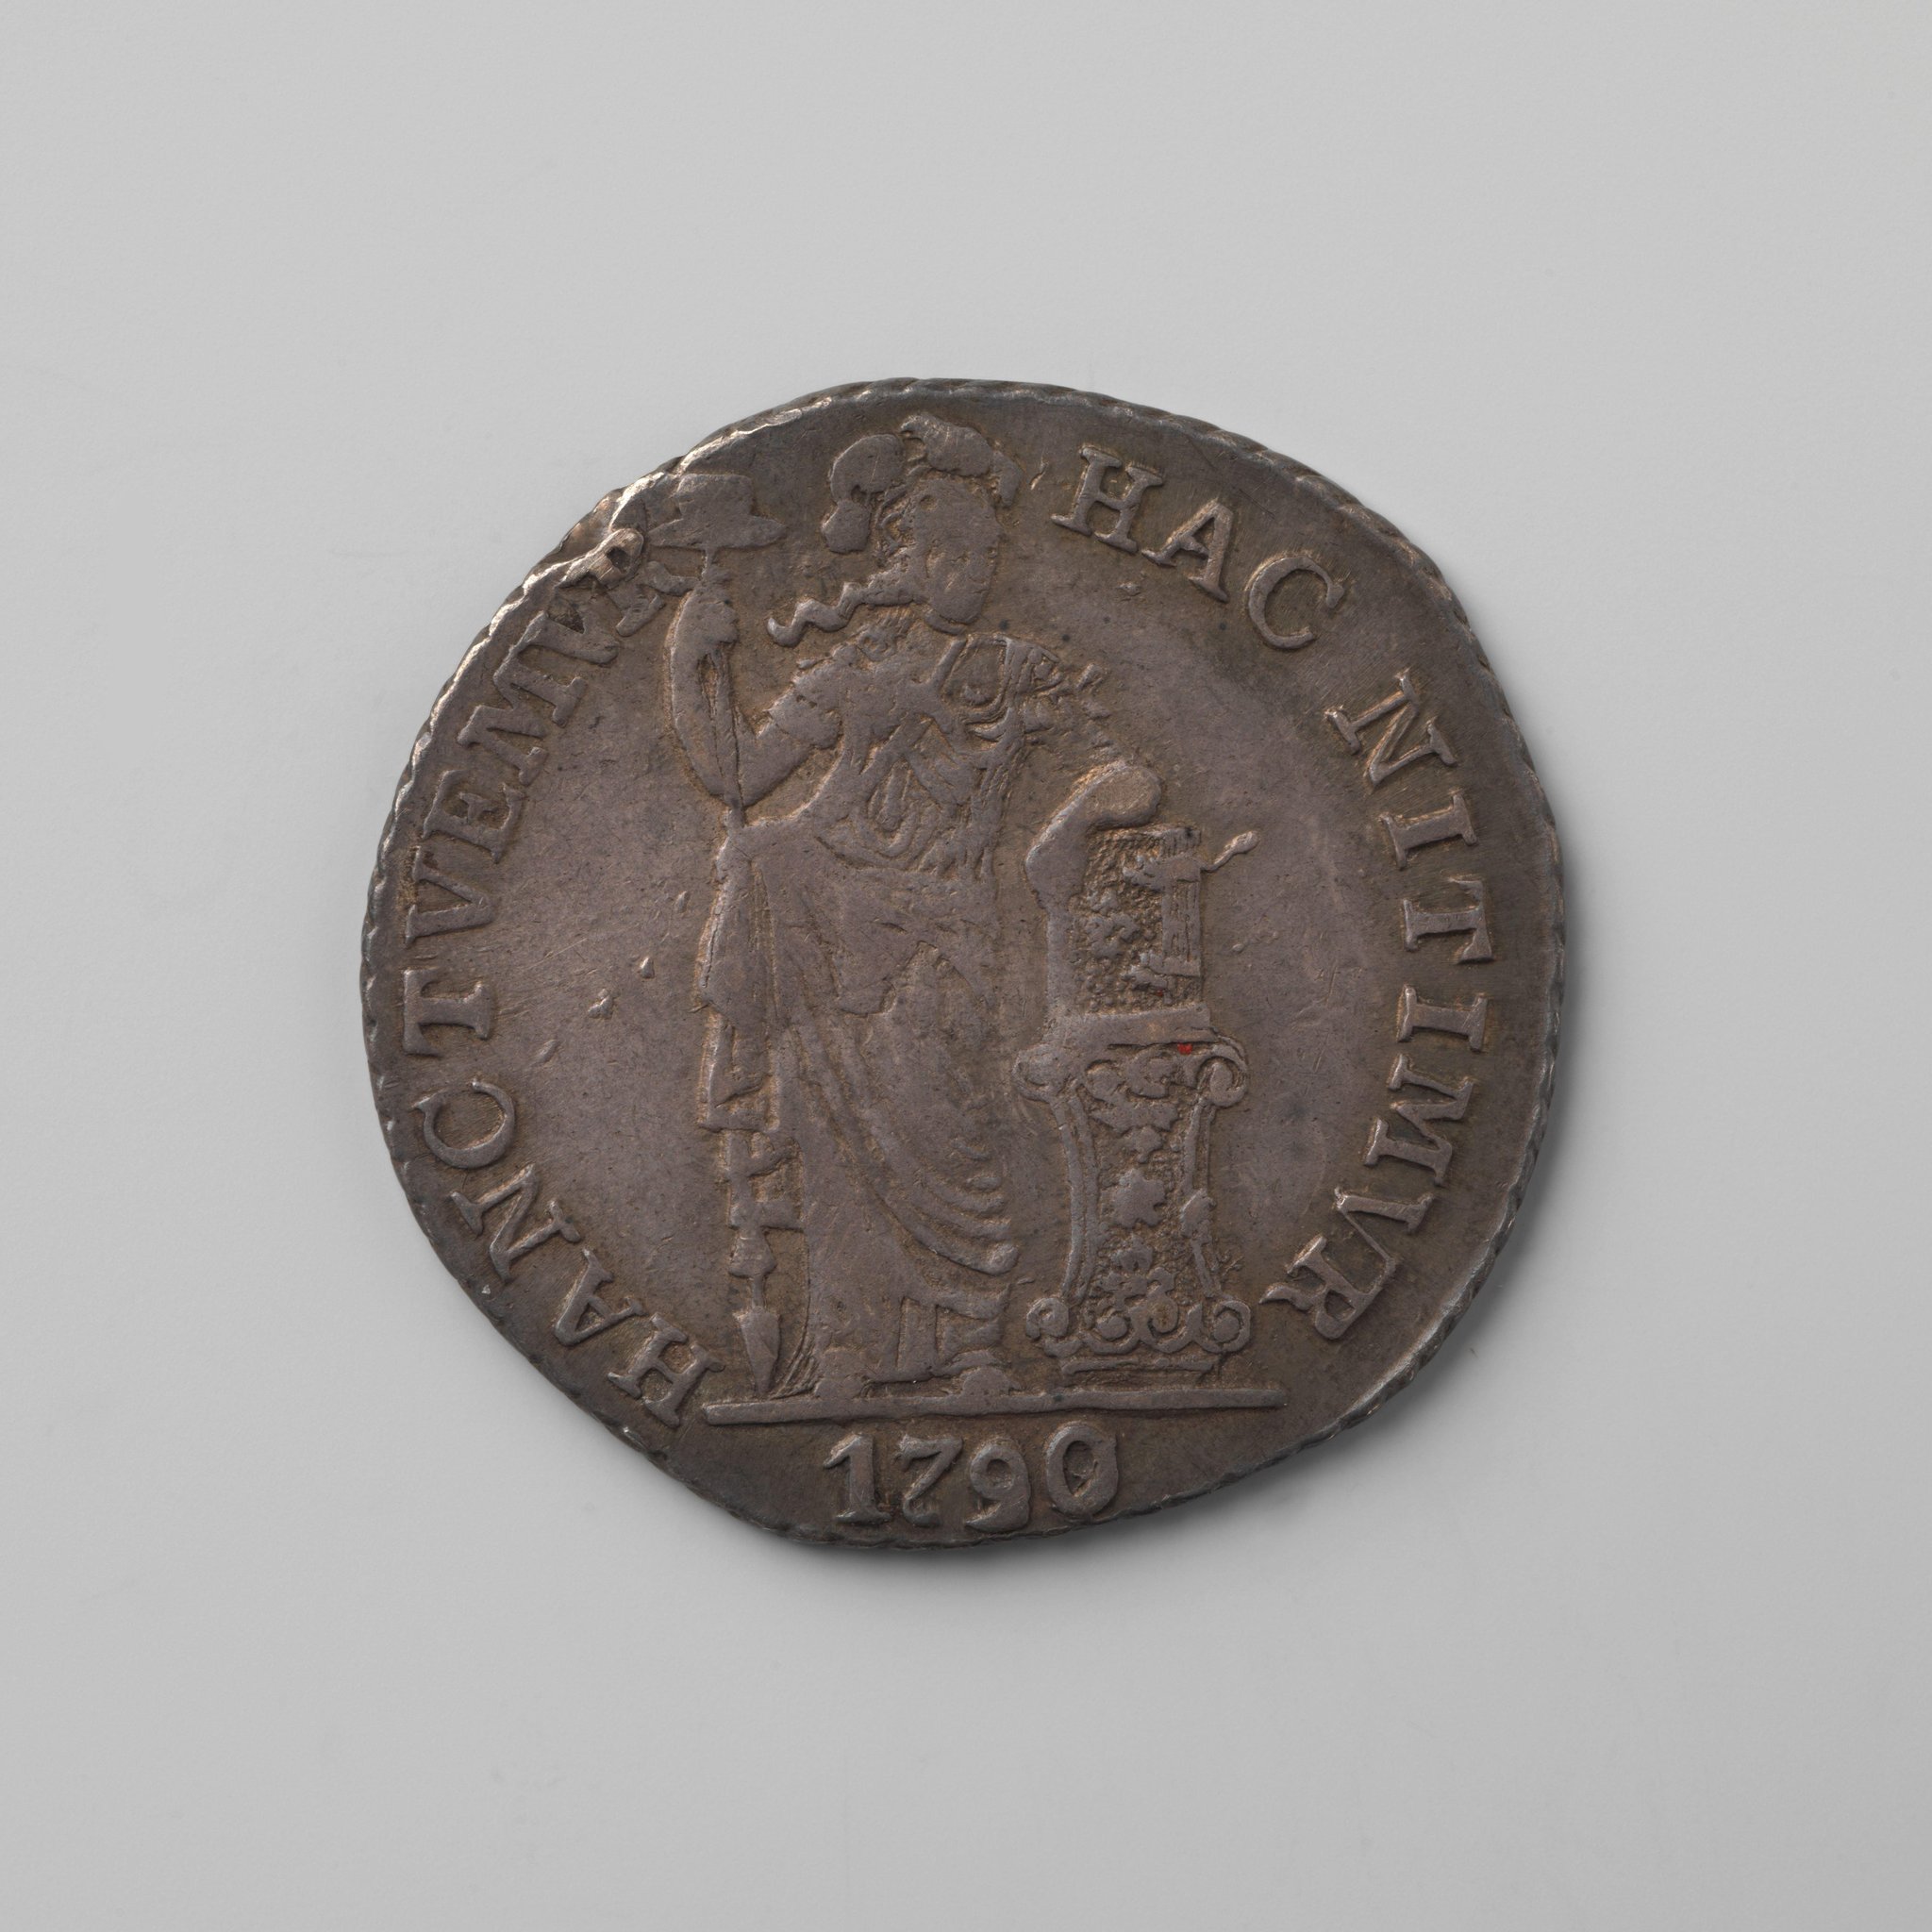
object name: coin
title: VOC, gulden, Westfriesland,1790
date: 1790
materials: silver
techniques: striking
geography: hoorn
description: Zilveren munt. Voorzijde: tussen waarde-aanduiding I Gl. gekroond generaliteitswapenschild, waaronder cartouche, waarin monogram van de VOC. Keerzijde: Nederlandse maagd met speer, waarop vrijheidshoed, leunend op een bijbel op een altaar. Jaartal in afsnede. Kabelrand.